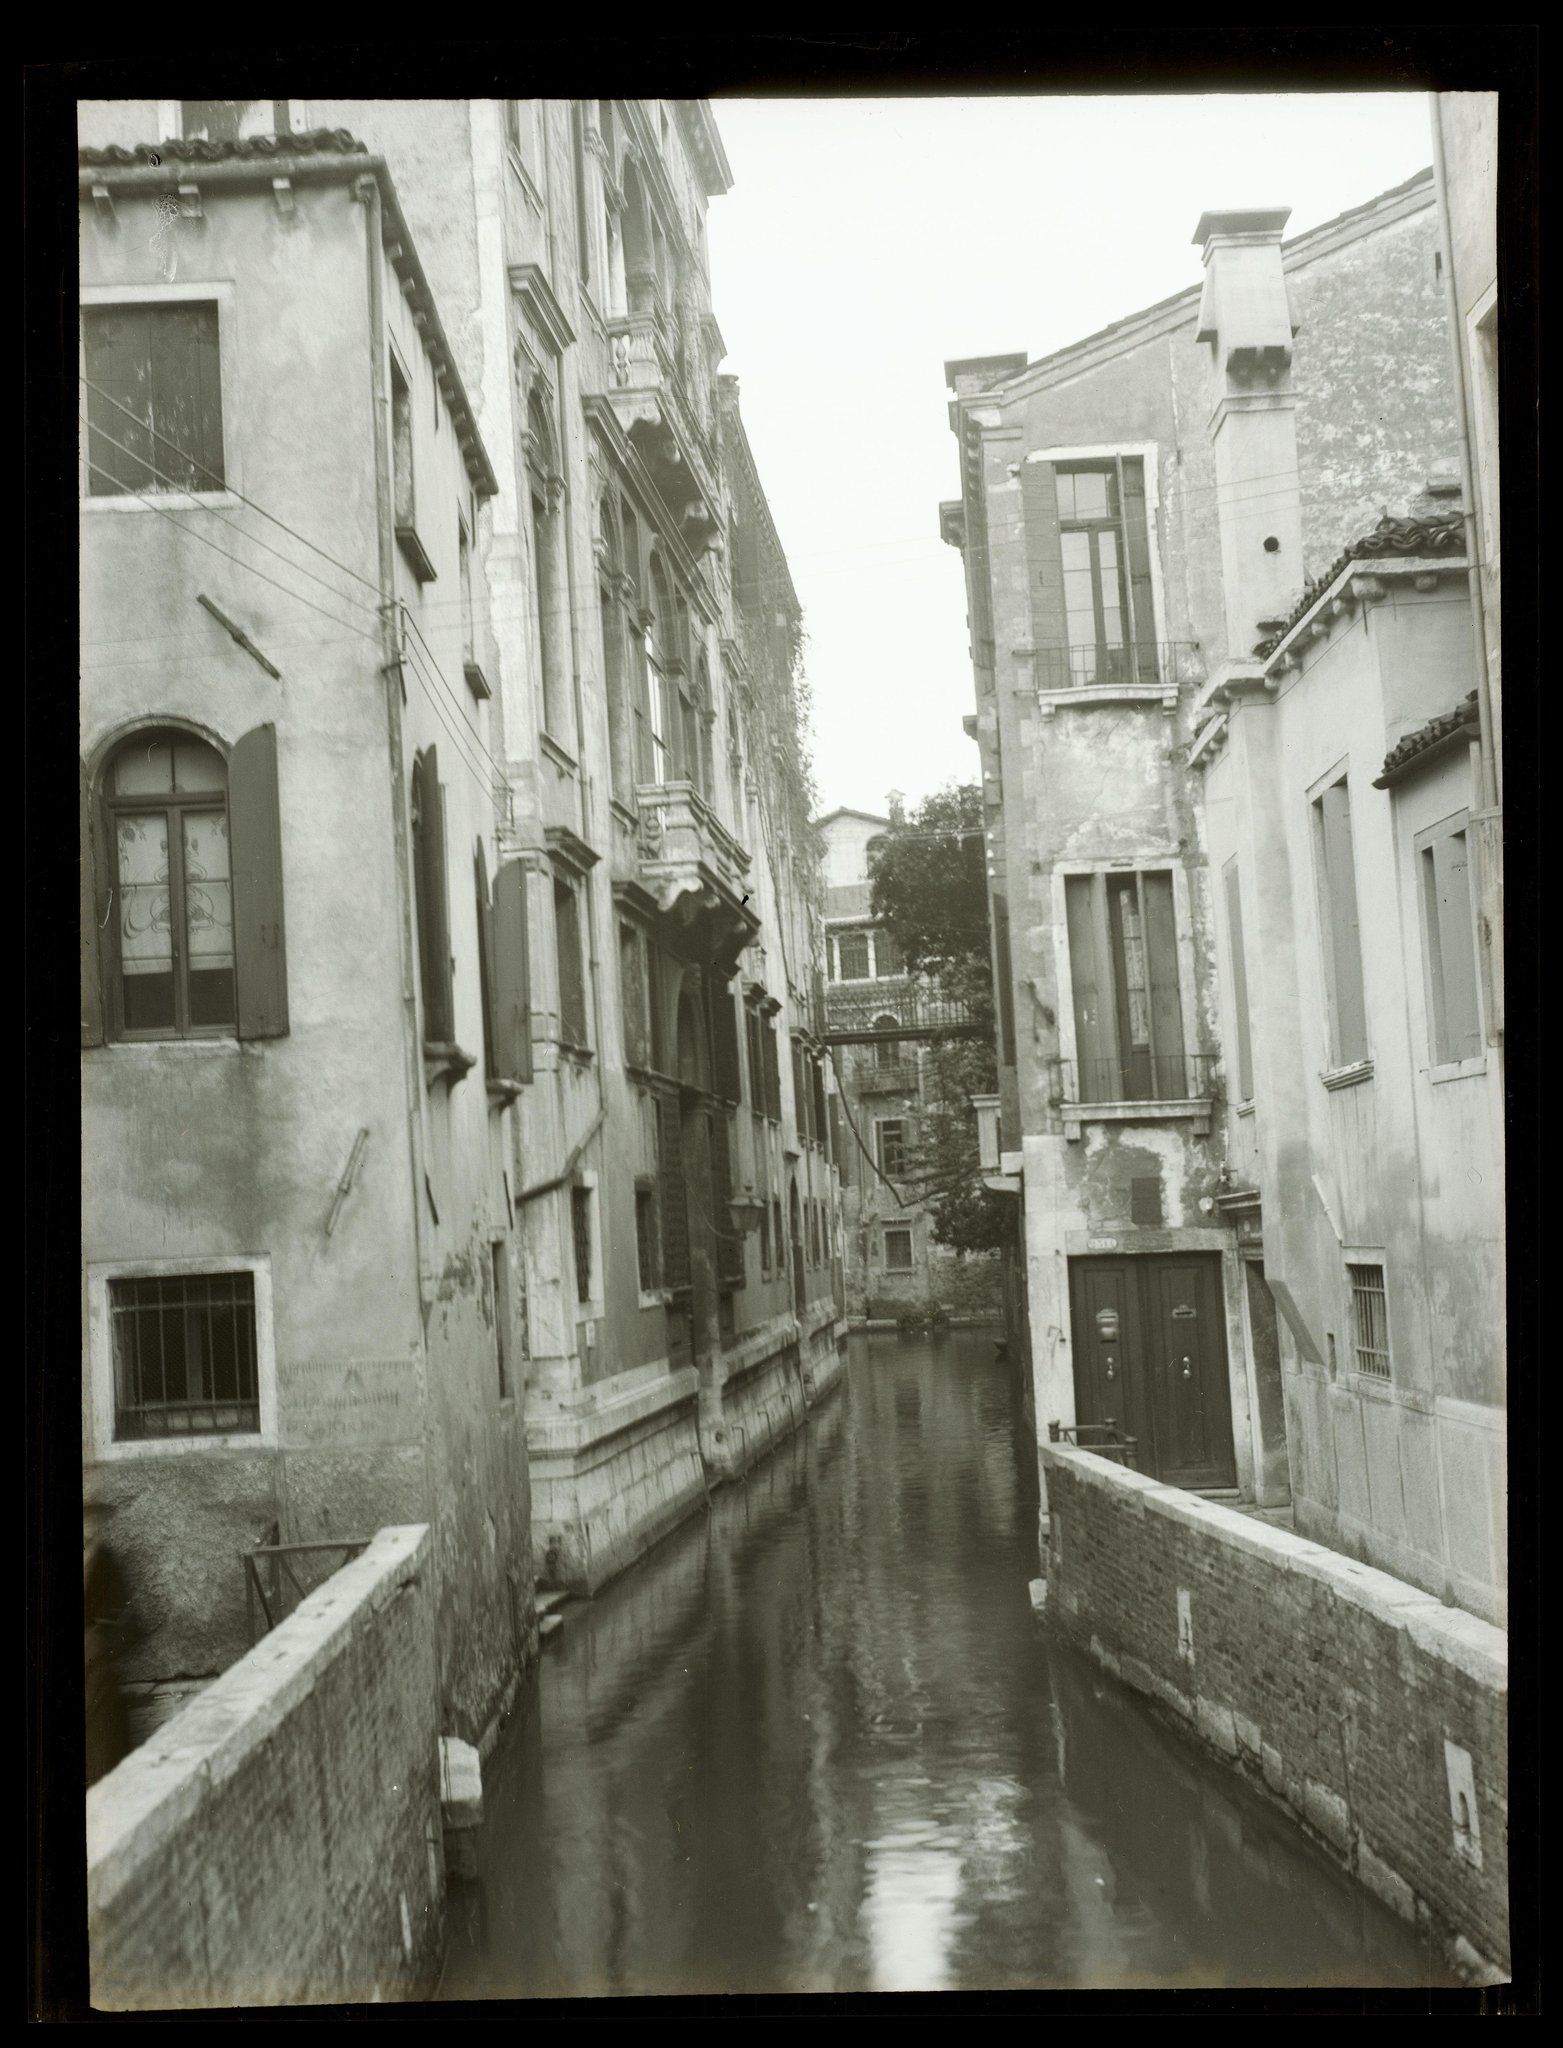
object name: negative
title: Filmnegatief met opname van Venetië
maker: Anonymous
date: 1907-1935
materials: film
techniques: gelatin silver negative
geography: venice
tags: venice